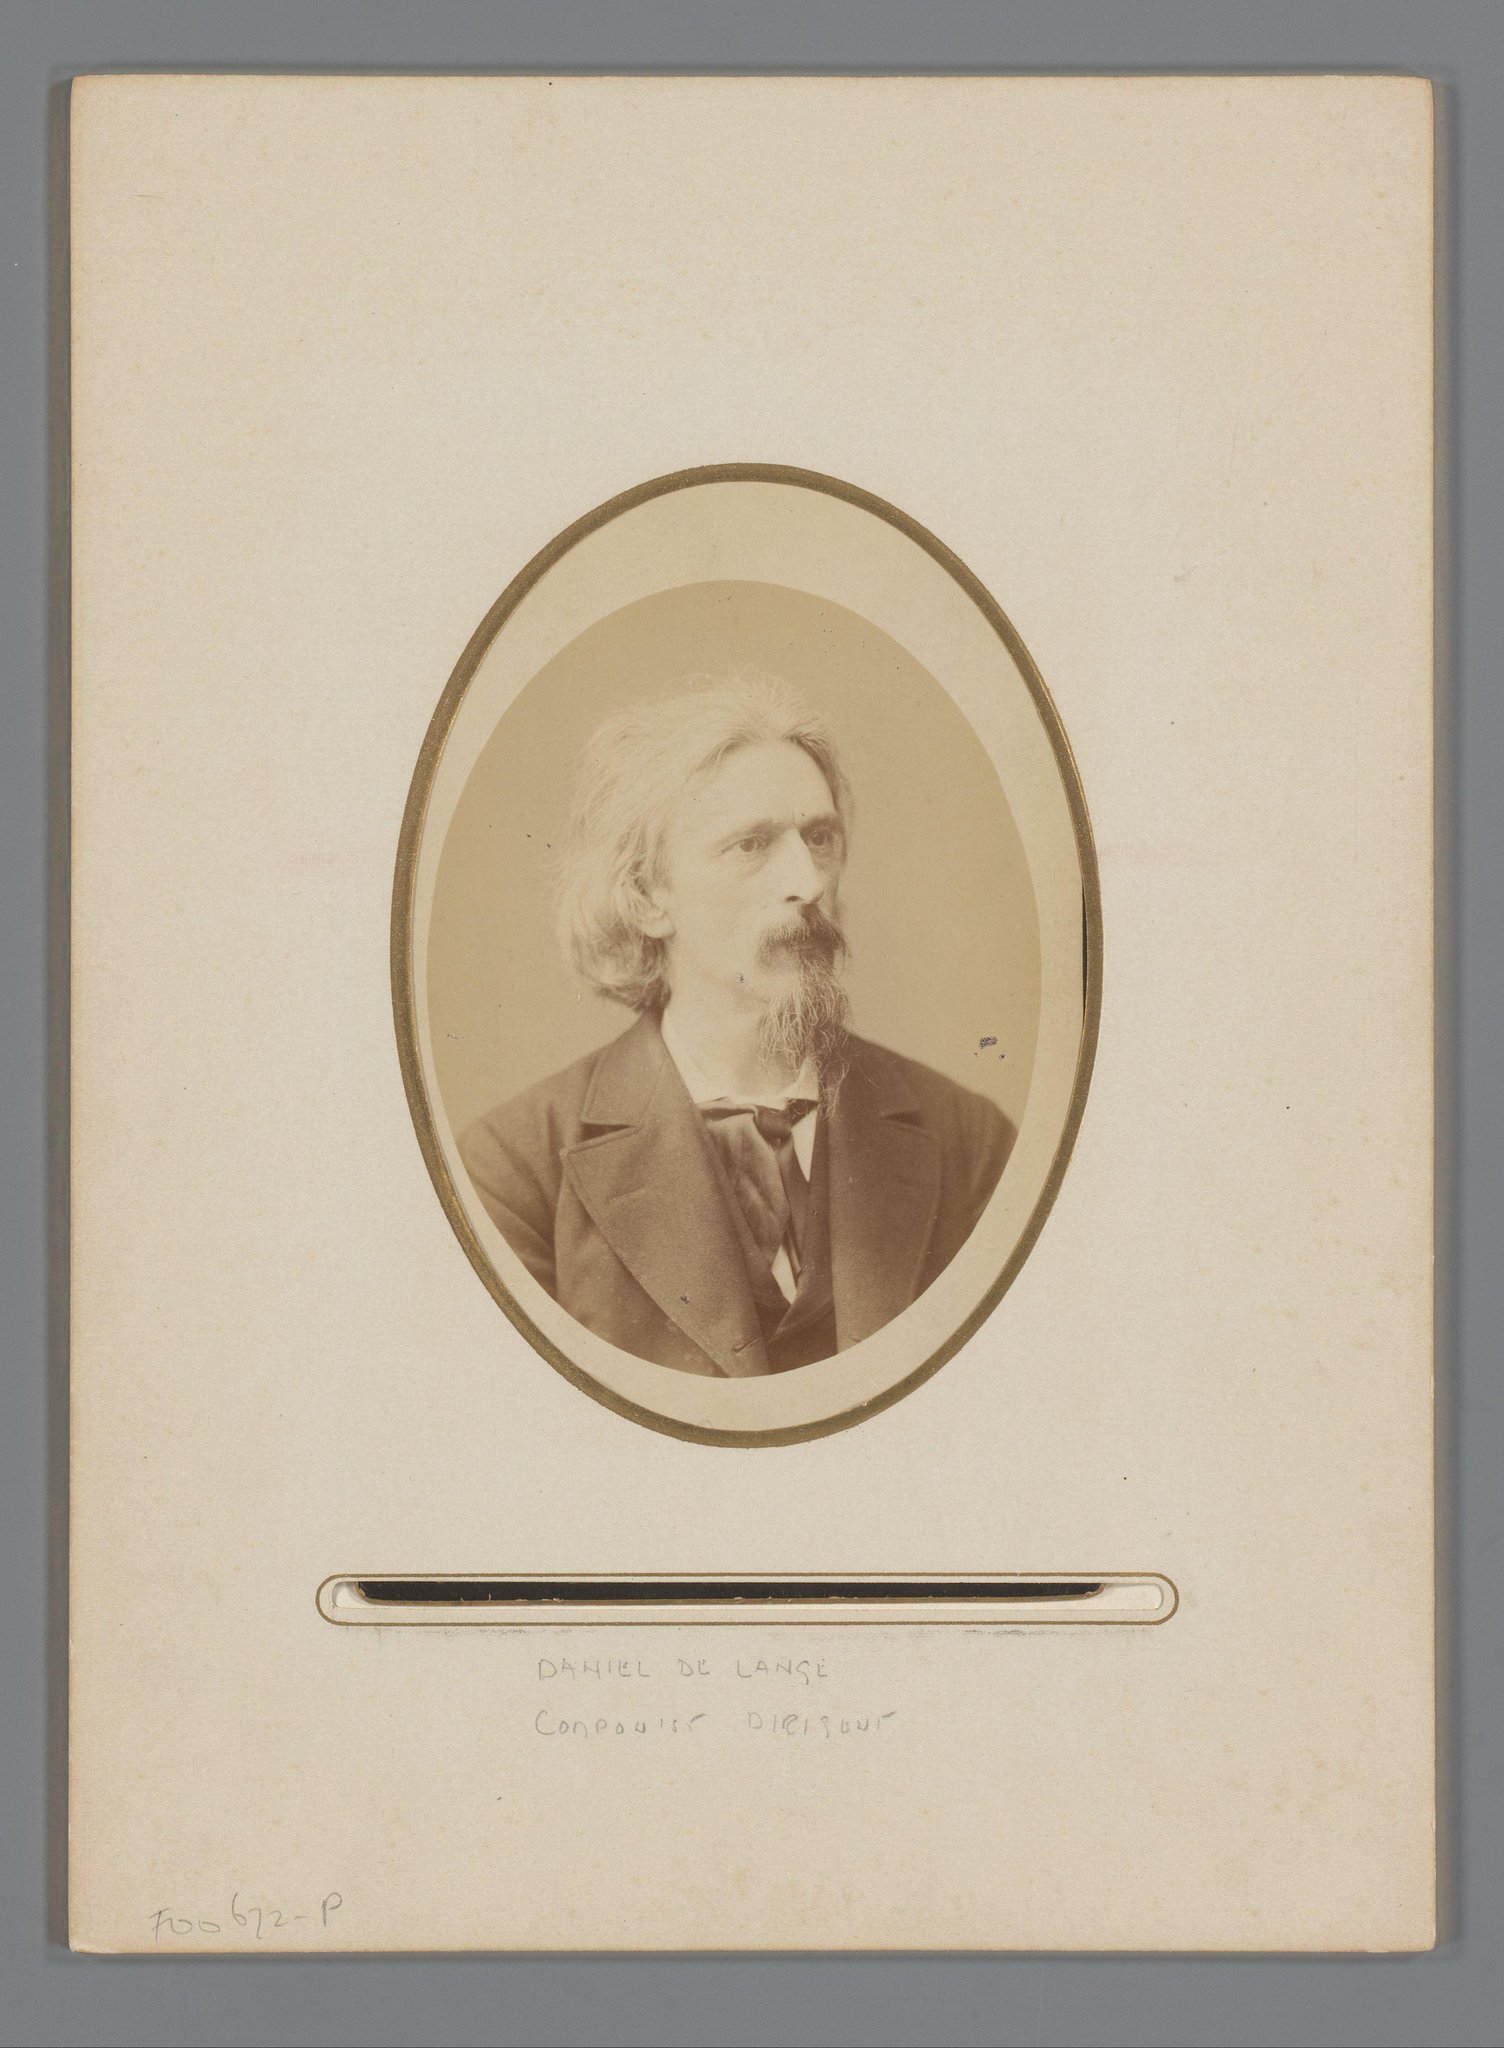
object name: cabinet photograph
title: Portret van componist en dirigent Daniël de Lange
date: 1870-1890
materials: cardboard, photographic support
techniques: albumen print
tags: rotterdam, adult man, historical persons, portrait of composer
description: Deze foto maakt deel uit van een omslag met 22 foto's.